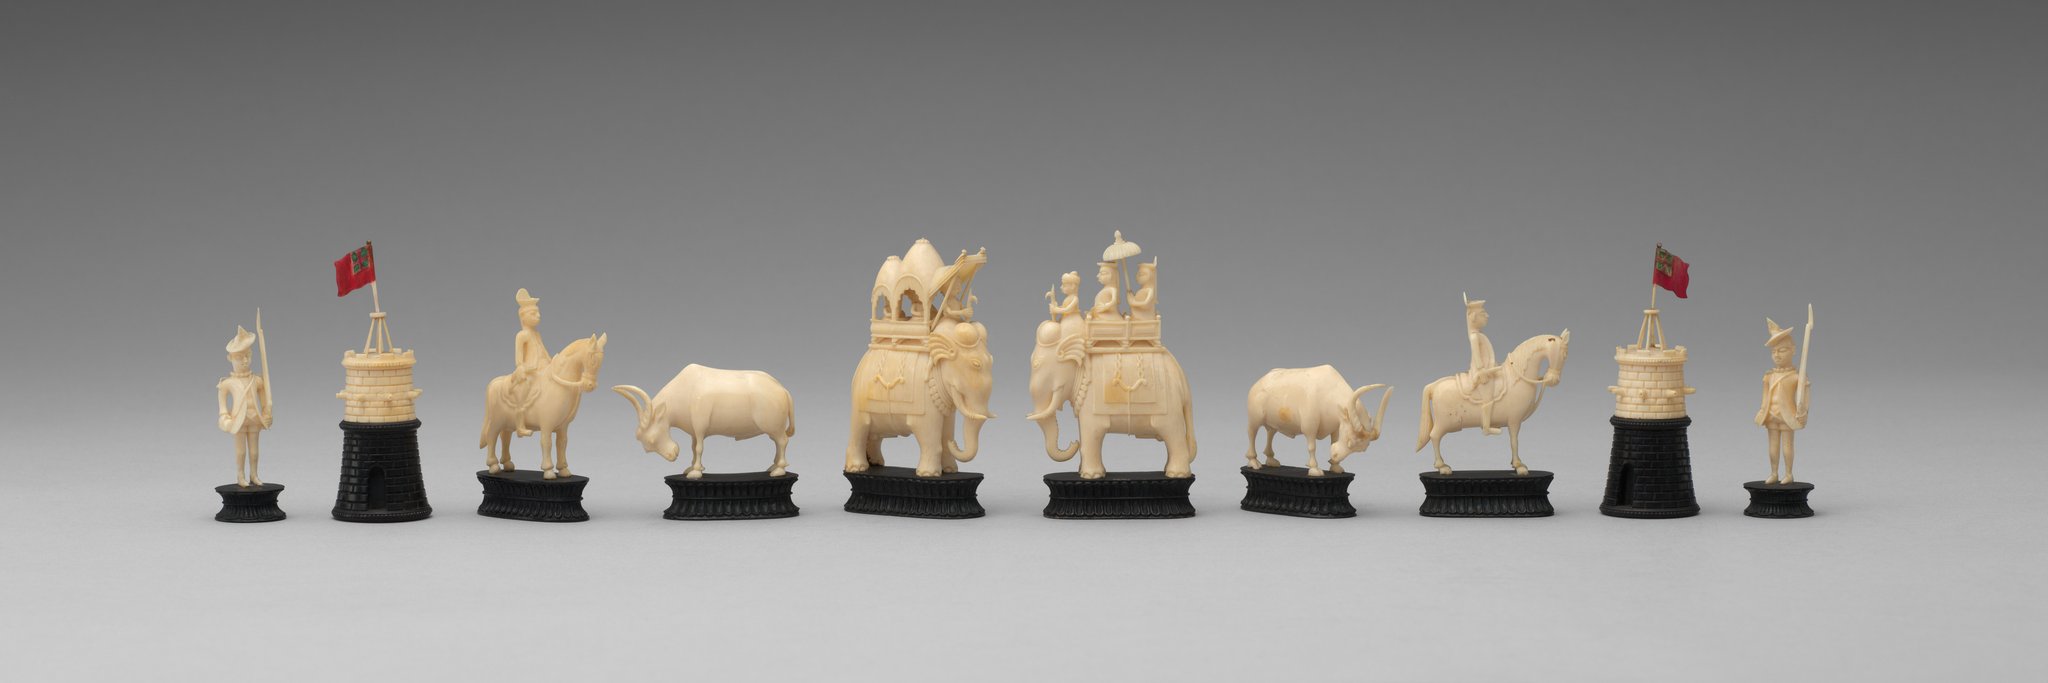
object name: chessman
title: Chessmen (32)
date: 1801-1900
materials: ivory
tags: chess